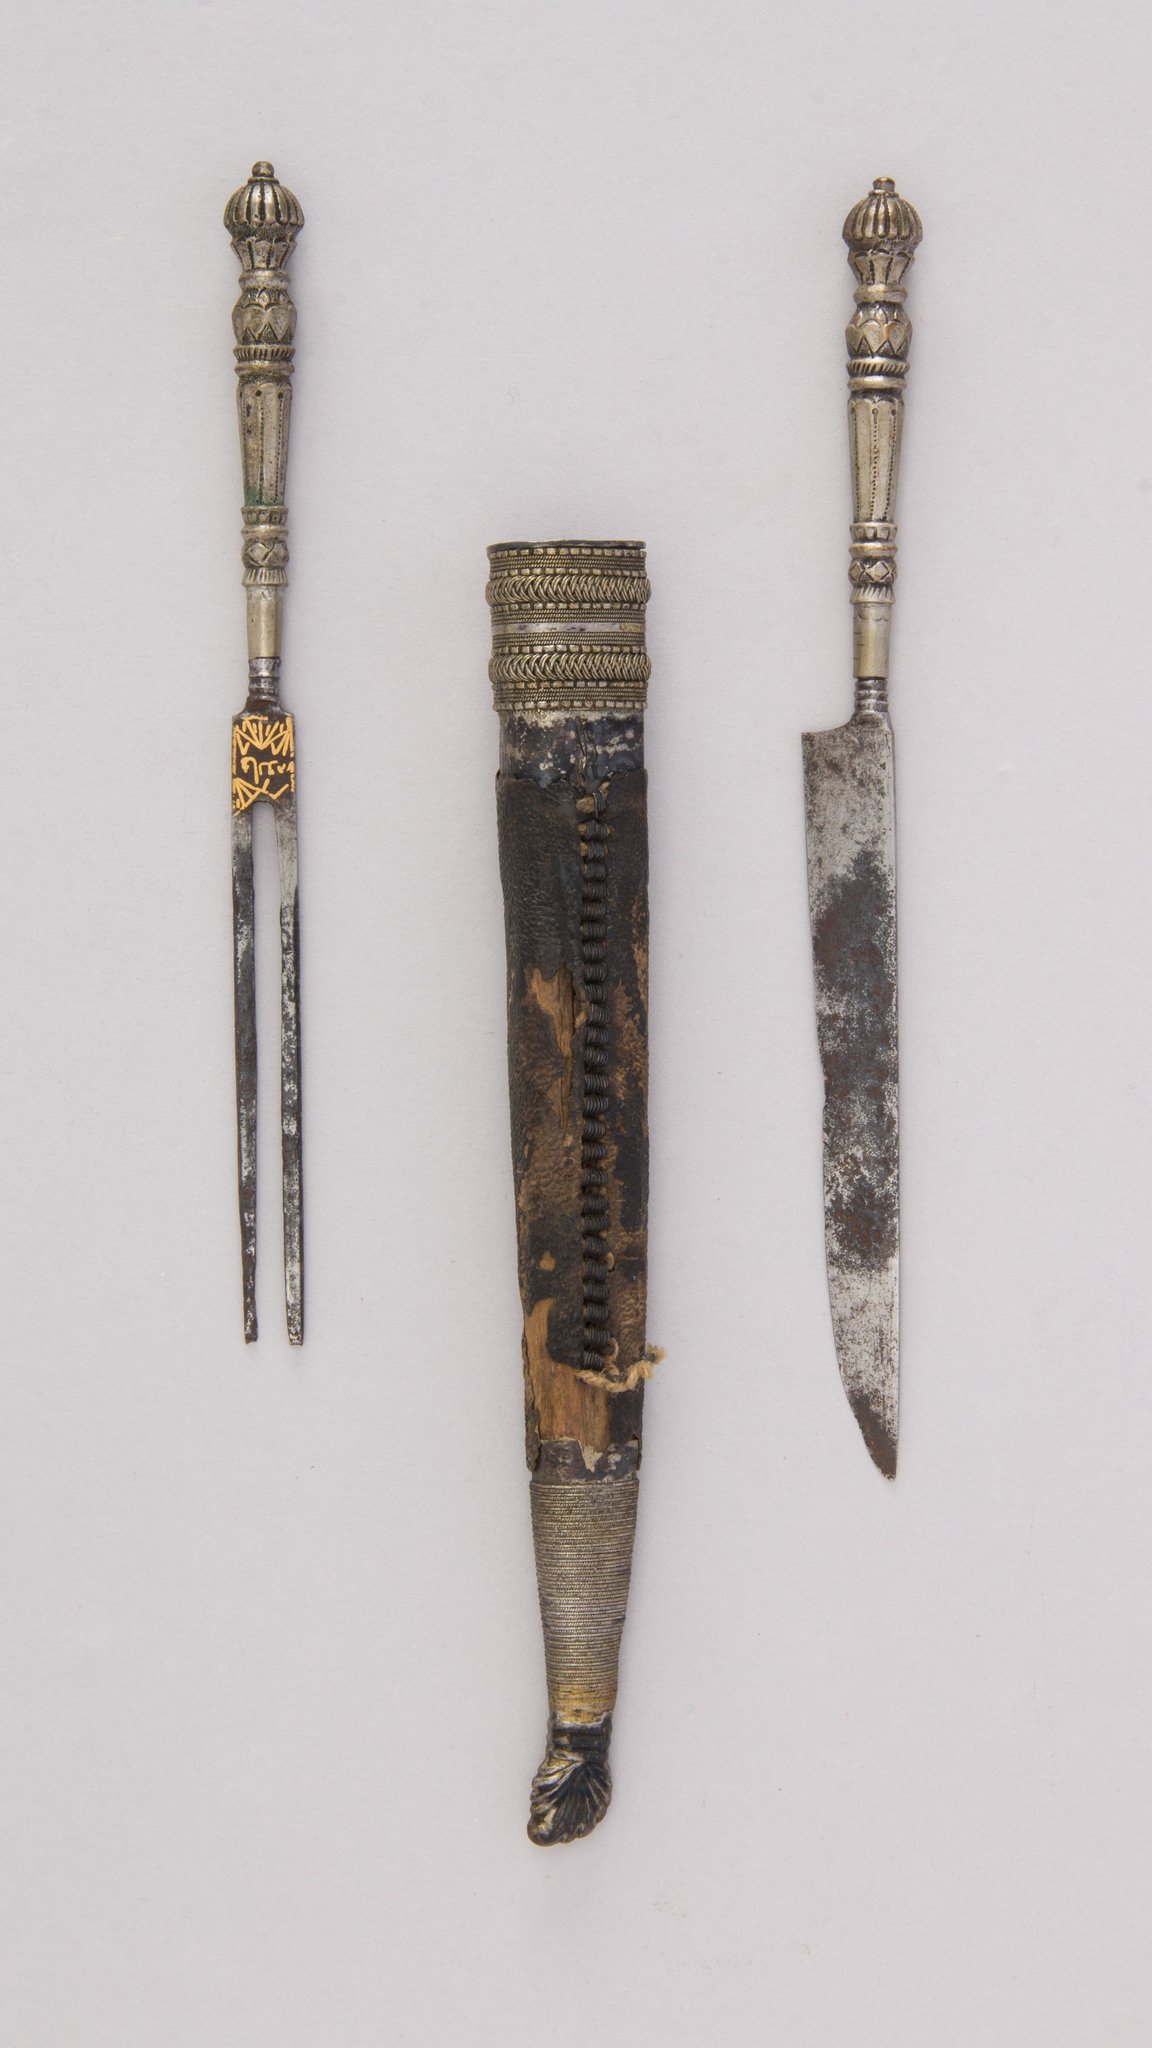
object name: knife and fork with sheath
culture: sri lankan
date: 1701-1800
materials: leather, silver, steel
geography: sri lanka